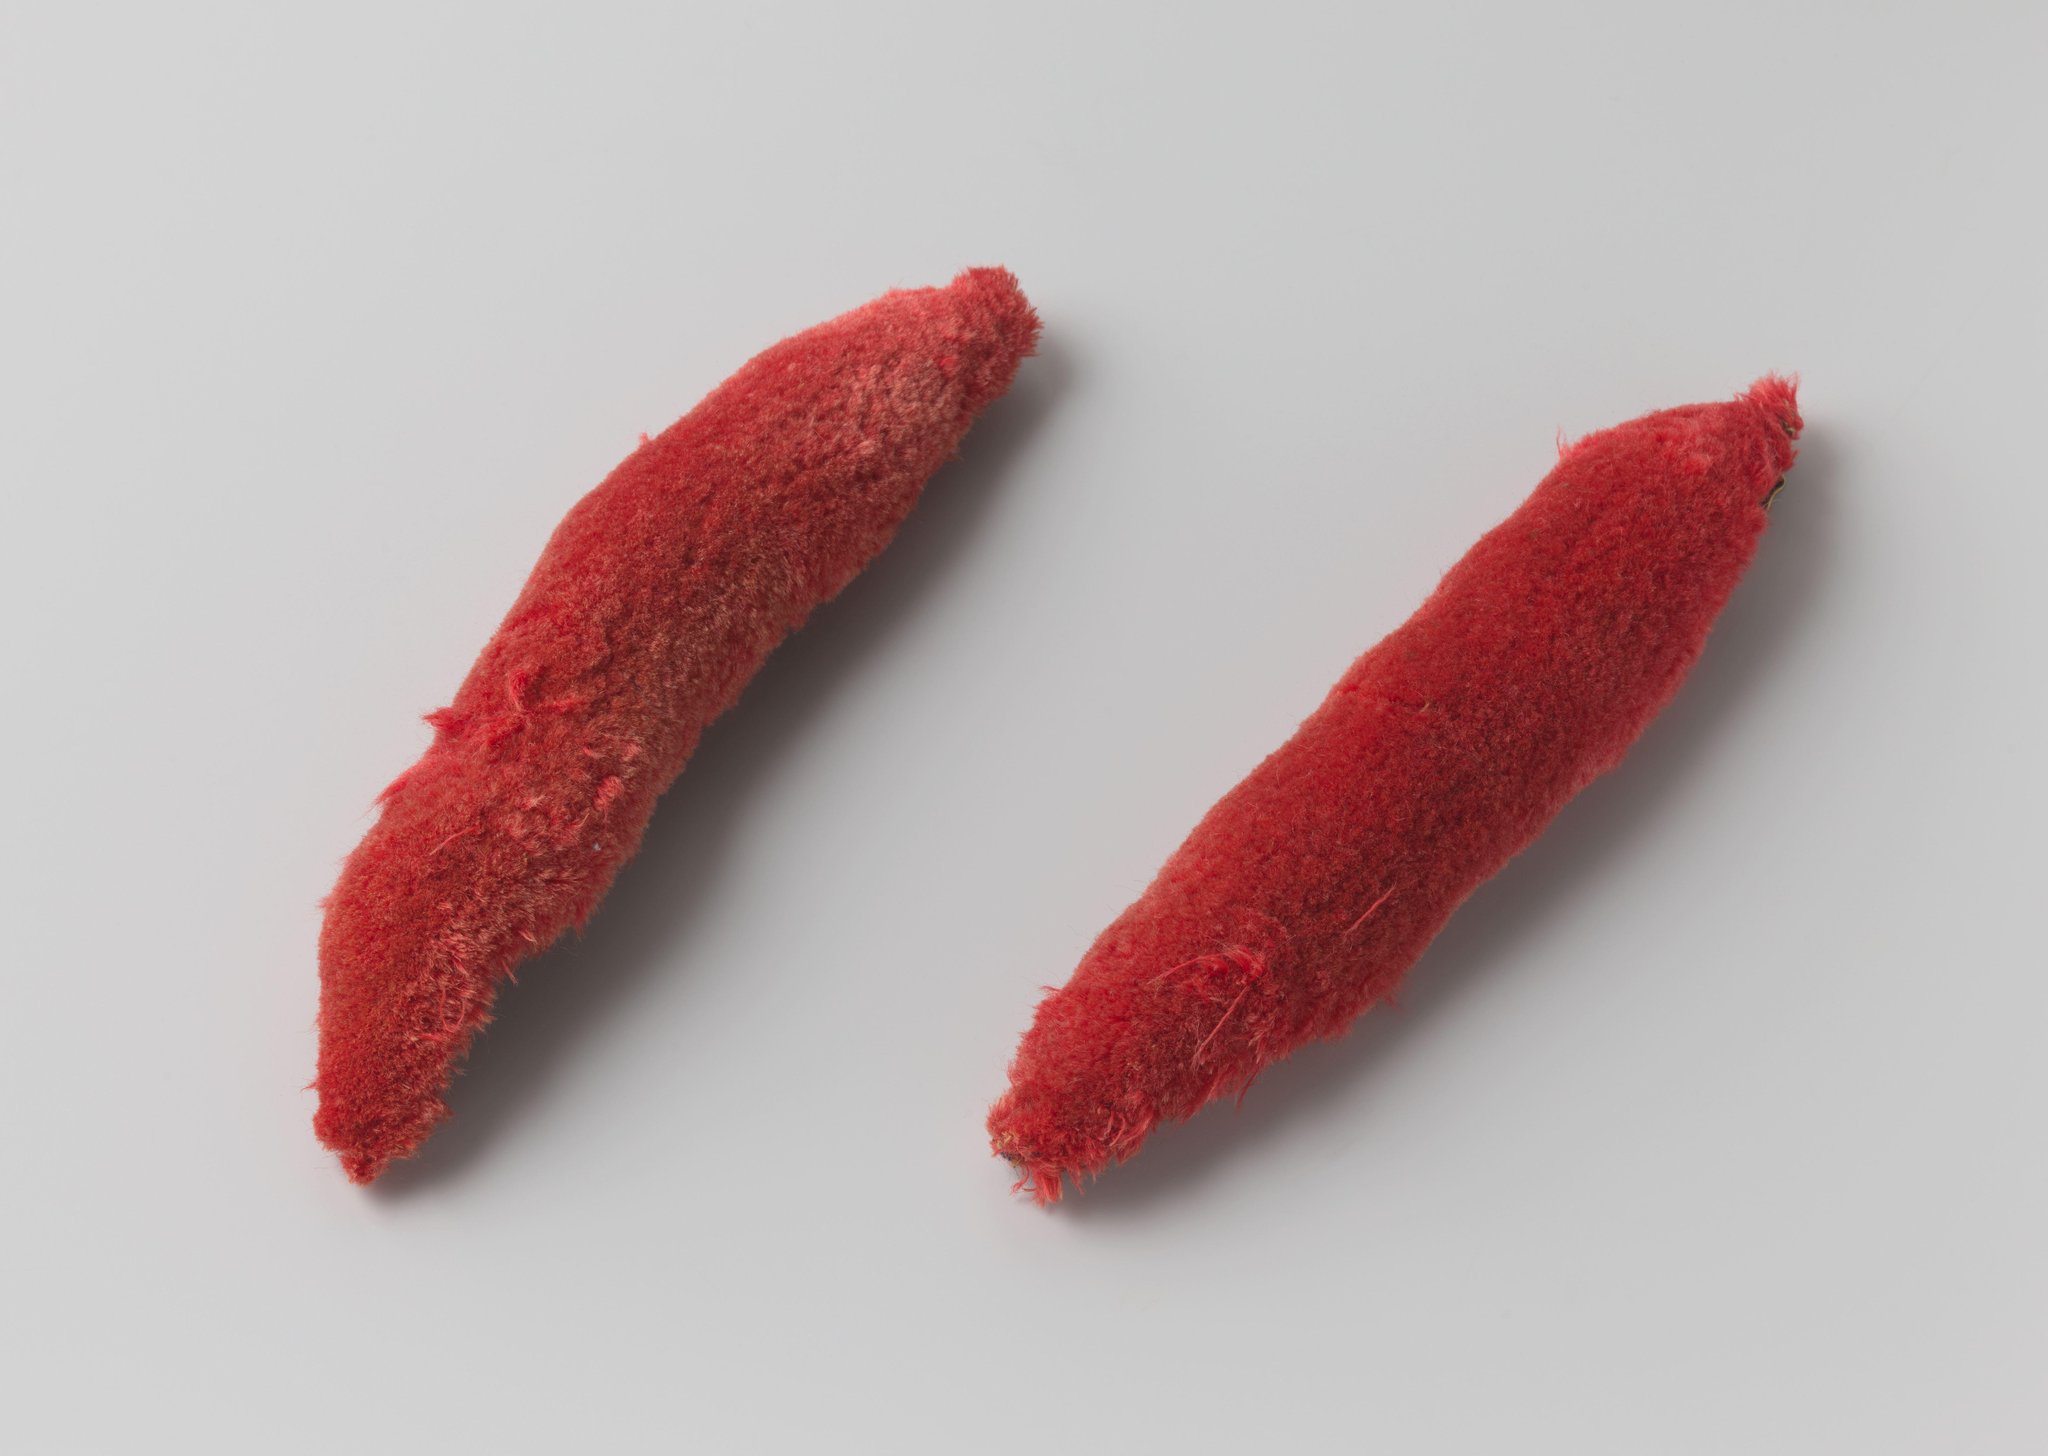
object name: wing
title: Wings, ovaal van wol met zwart grijze voering en geel metalen haken, voor schutters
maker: Anonymous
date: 1840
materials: metal, wool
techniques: stitching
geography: netherlands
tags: netherlands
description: Ovale wollen schouderbedekking met zwart grijze voering en voorzien van geel metalen haken. Een buitenmodel wings, gezien de afwerking, voor schutters.